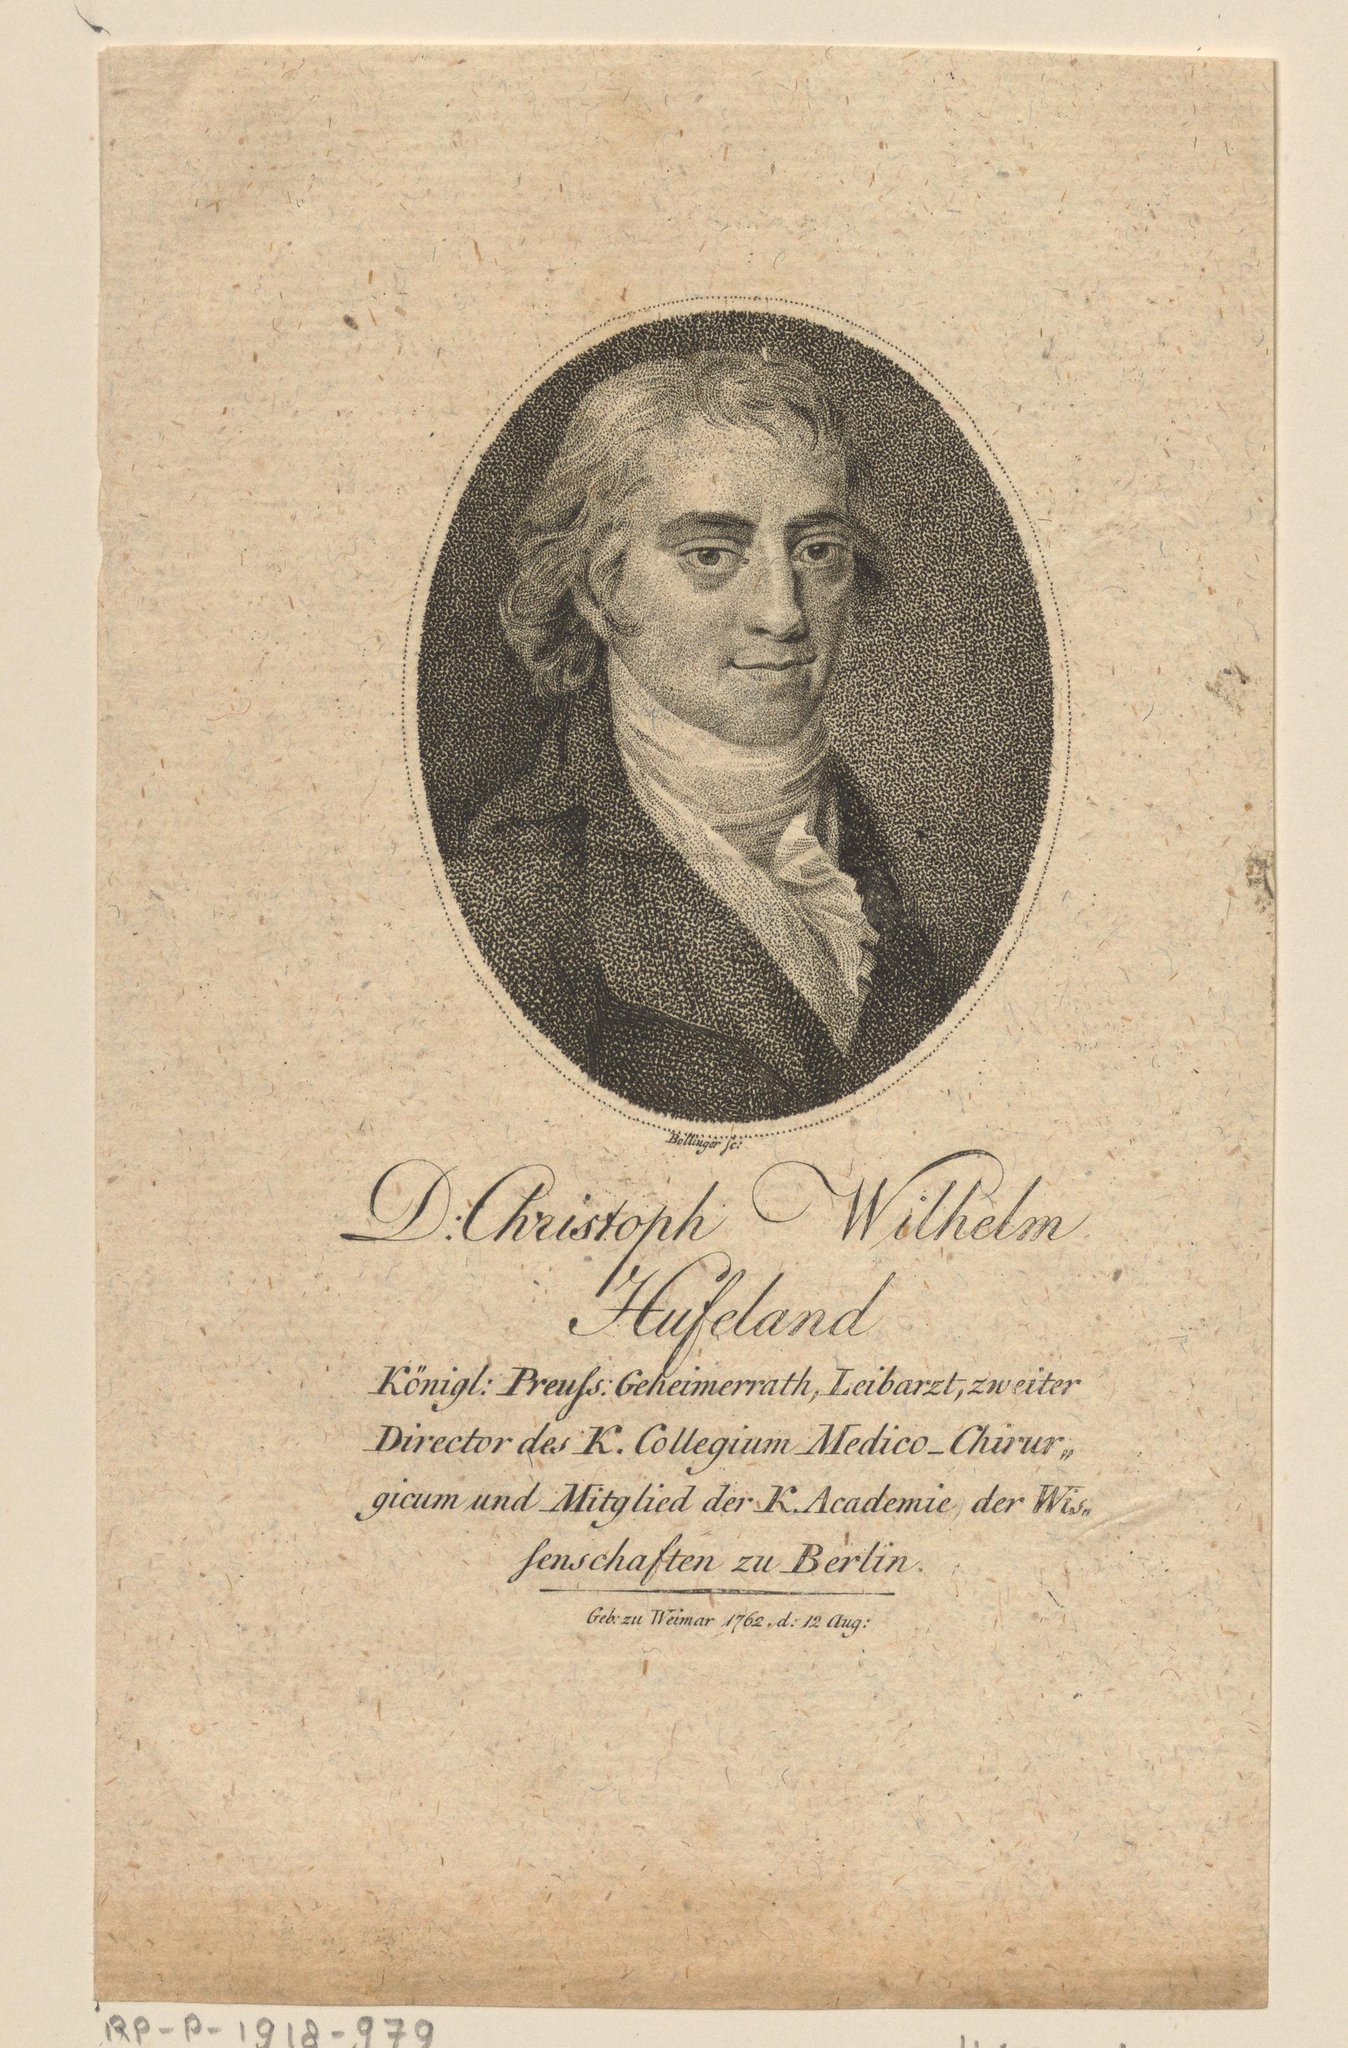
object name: print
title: Portret van Christoph Wilhelm von Hufeland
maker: friedrich wilhelm bollinger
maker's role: print maker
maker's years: 1777-1825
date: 1798-1825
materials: paper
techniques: etching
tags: berlin, historical persons, physician, doctor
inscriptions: collector's mark: Lugt 2233